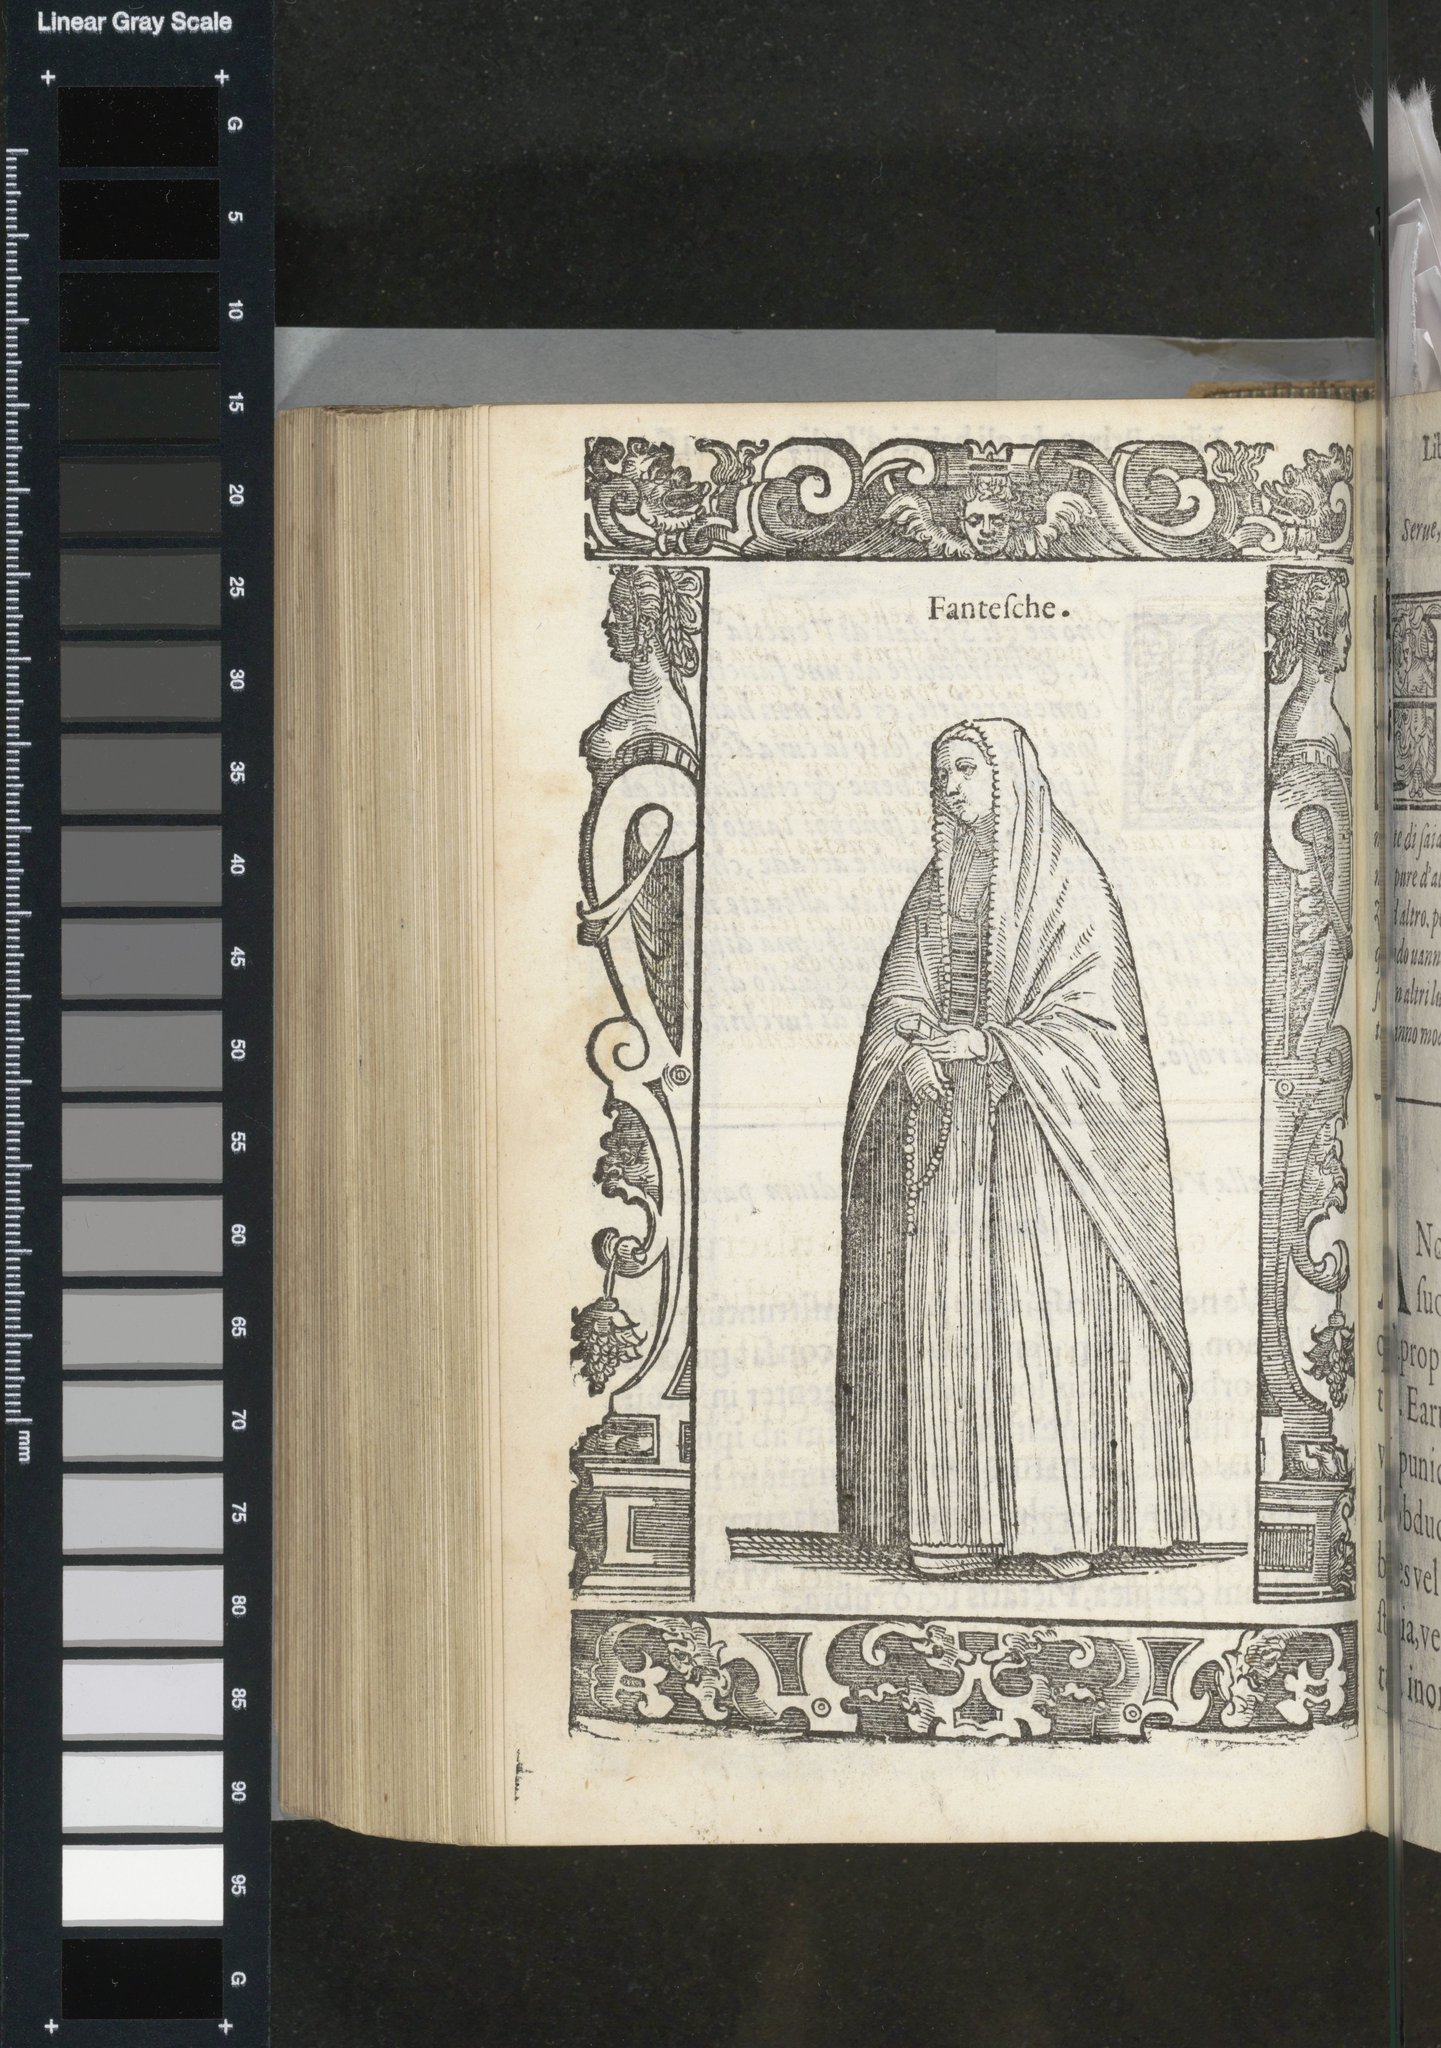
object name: costume print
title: Fantesche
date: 1598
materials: paper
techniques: woodcut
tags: veil (+ women's clothes), missal, aids for prayer, e.g. rosary, fashion plates, dress, gown (+ women's clothes), maid ~ house personnel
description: Vrouw in eenvoudig overkleed waarover een grote omslagdoek die over het hoofd is geslagen. Rozenkrans en missaal in de handen. In ornamentrand.